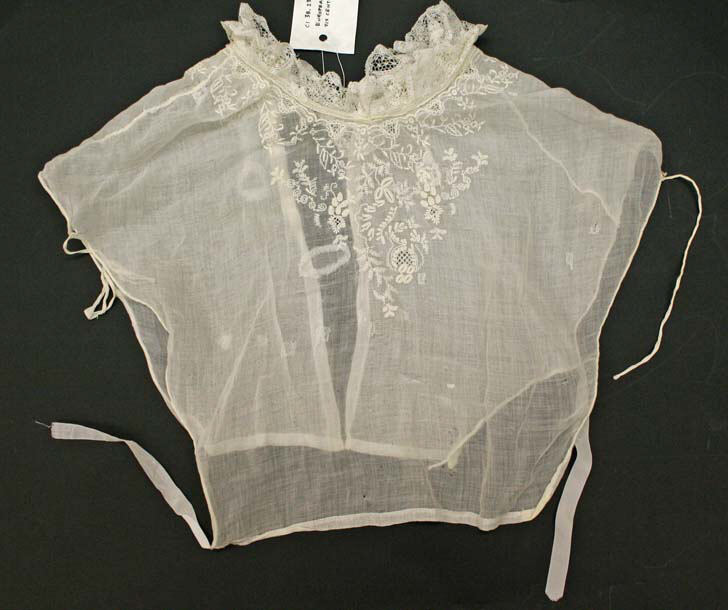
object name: vestee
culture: european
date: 1834-1866